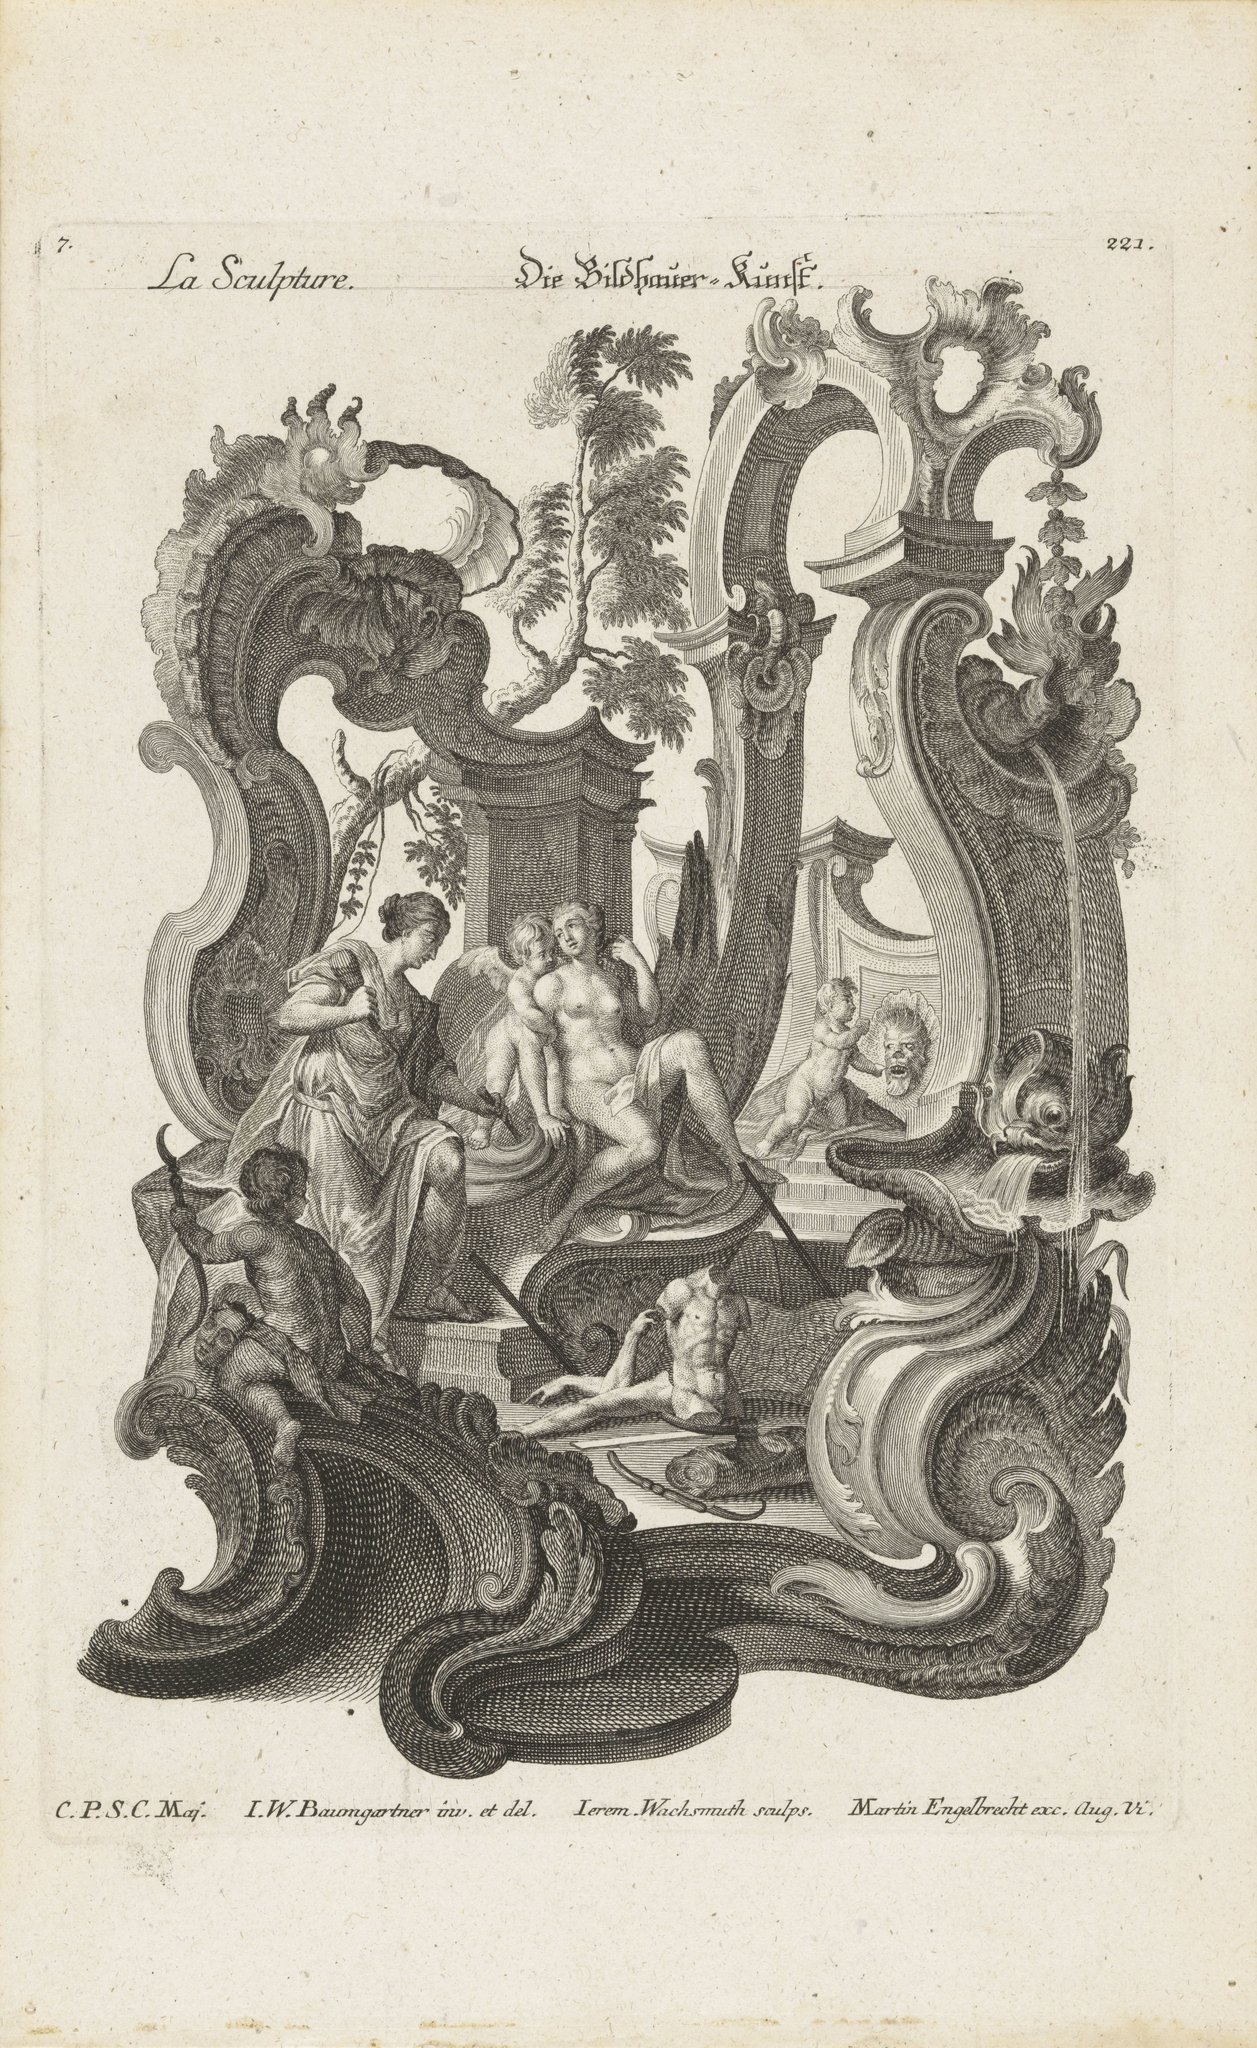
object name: ornament print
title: De zeven vrije kunsten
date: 1719-1749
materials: paper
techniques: engraving, etching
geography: augsburg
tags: rocaille ornament, sculptor at work, 'sculptura', symbolic representations, allegories and emblems ~ sculpture; 'scoltura' (ripa), 'bocca della verità' (woman accused of adultery putting her hand into sculpted figure's mouth to prove her innocence)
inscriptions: collector's mark: Lugt 2760, collector's mark: Lugt 2228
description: De Beeldhouwkunst of Sculptura werkt met beitel en hamer aan een beeld van Venus en Amor. Op de voorgrond een torso en enkele ledematen. Linksvoor een putto met boog. Rechtsachter een putto voor de Bocca della Verità (Mond der Waarheid). Rechtsboven 221 genummerd.